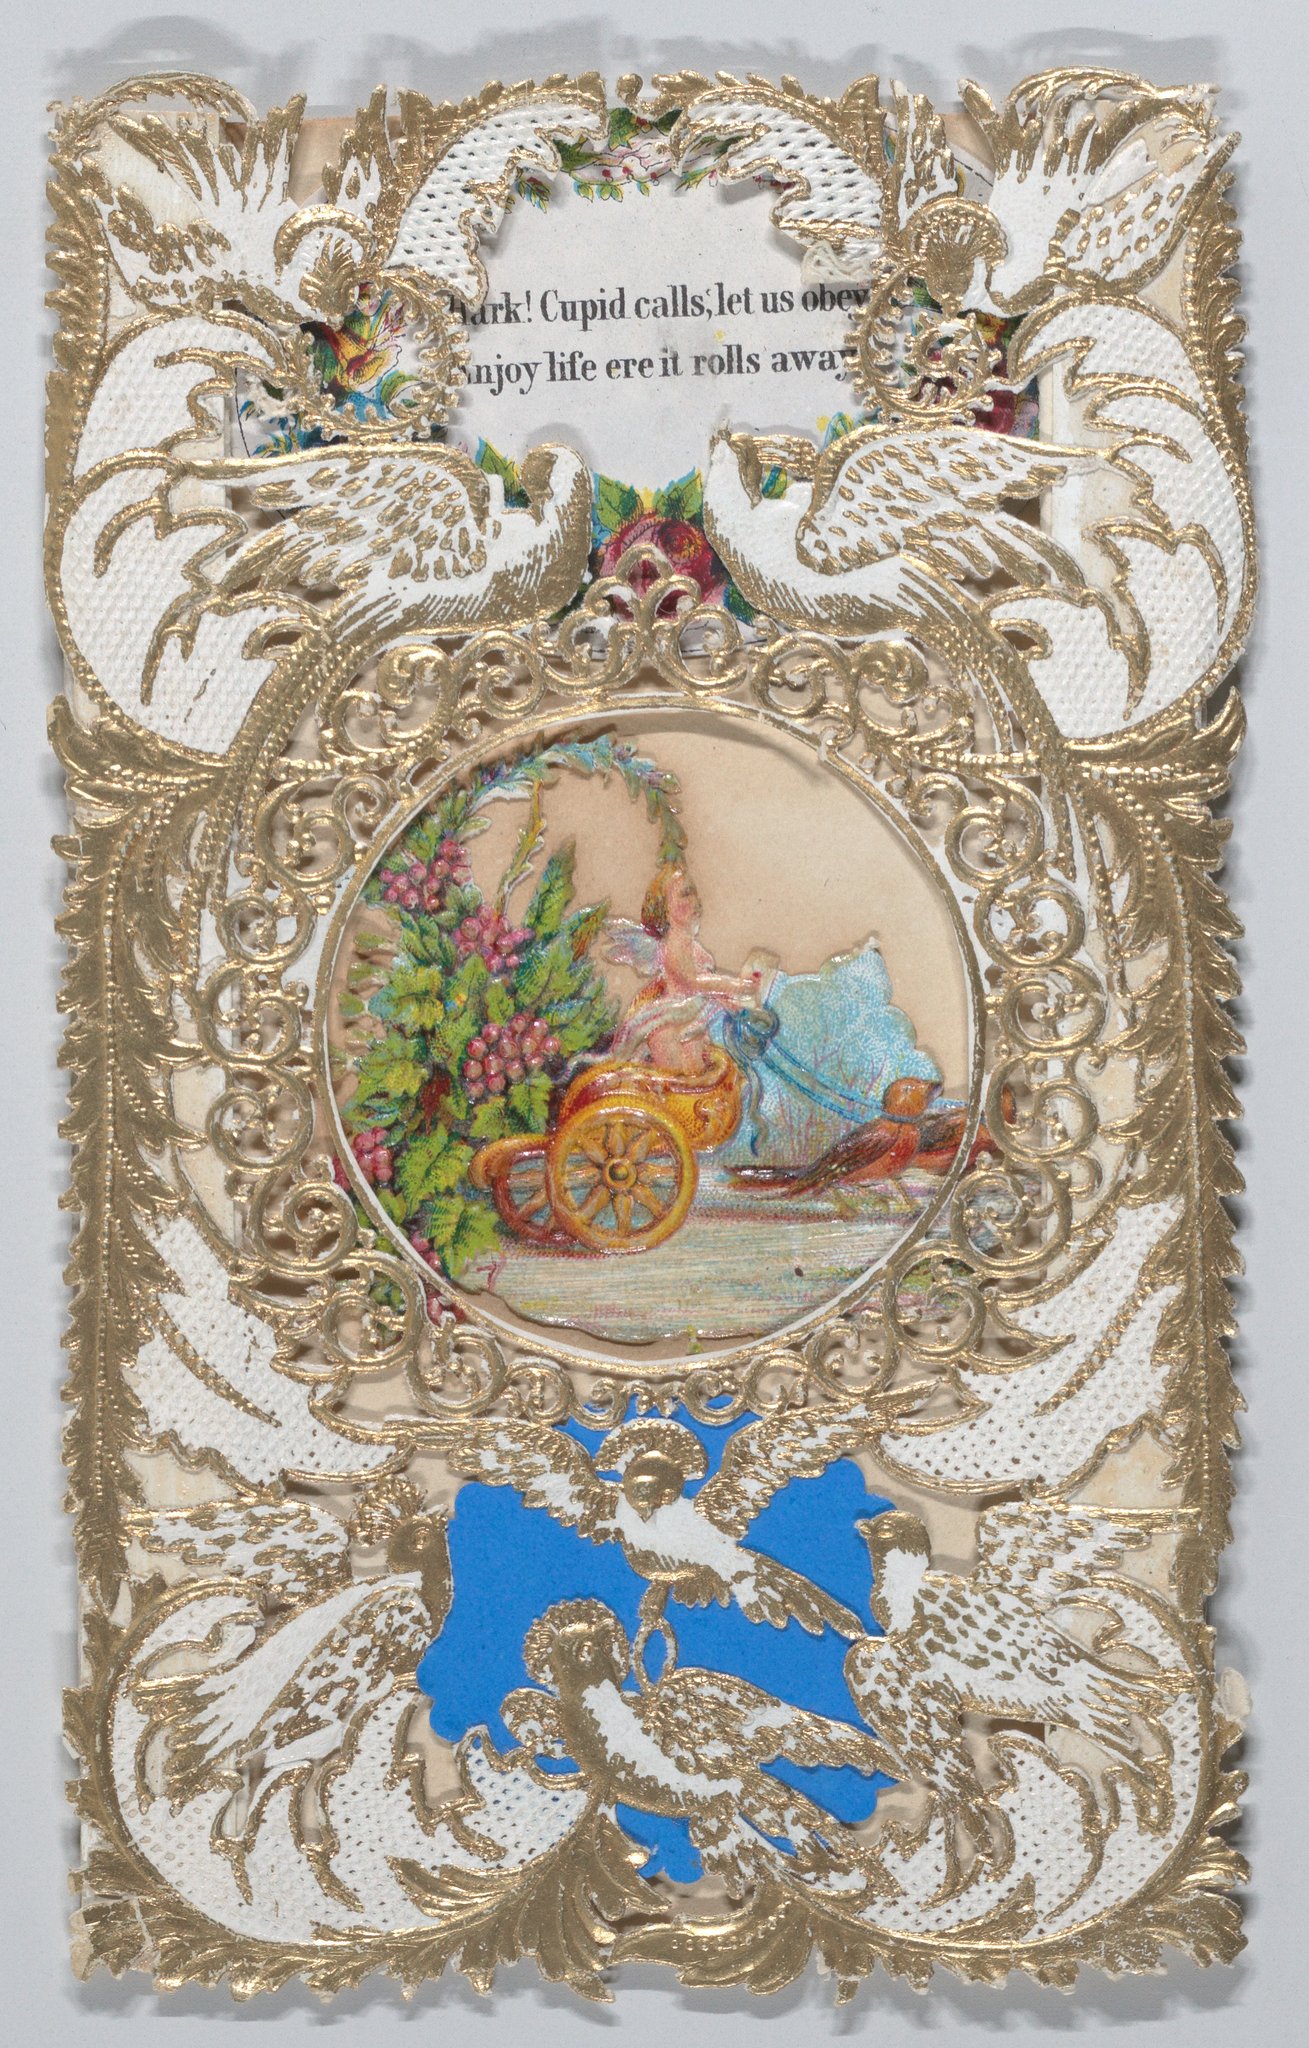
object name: valentine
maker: Anonymous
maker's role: artist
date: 1850-1860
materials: lace, paper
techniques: cutting, embossing, gilding, open work